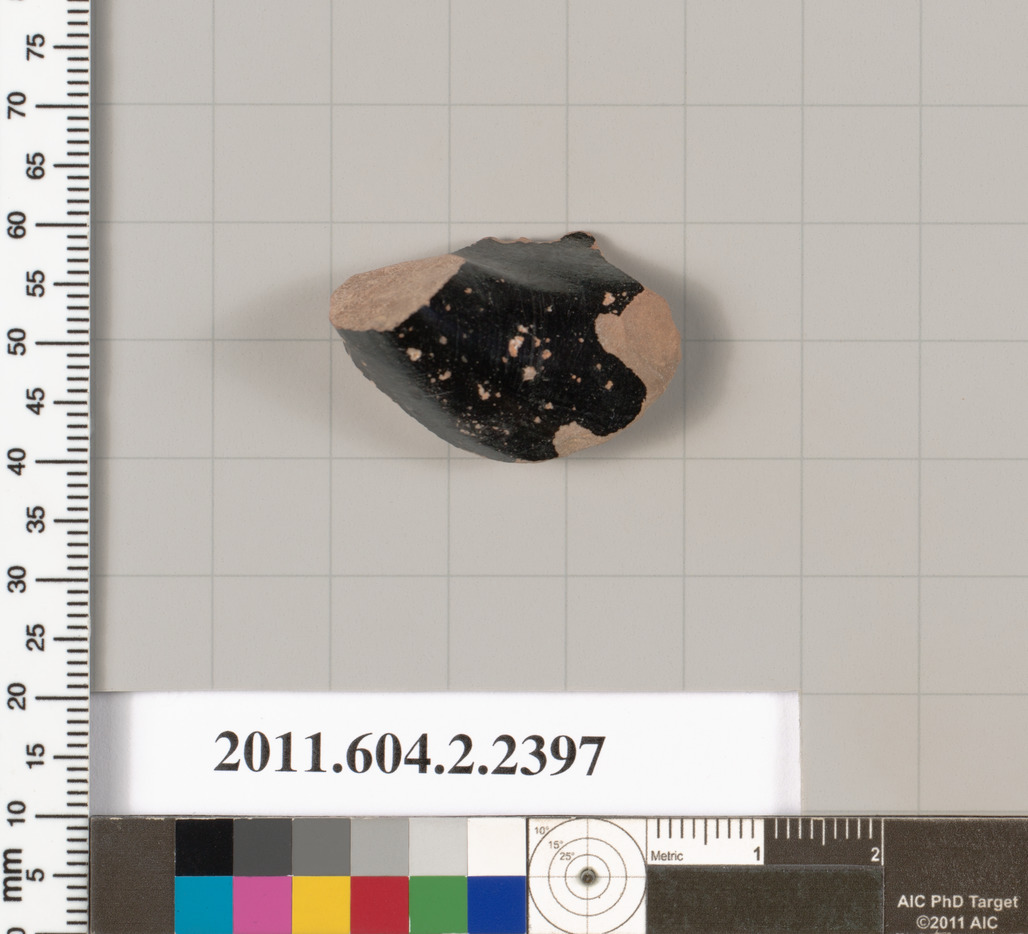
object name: skyphos fragment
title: Terracotta fragment of a skyphos (deep drinking cup)?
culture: greek, attic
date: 600-401 BCE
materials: terracotta